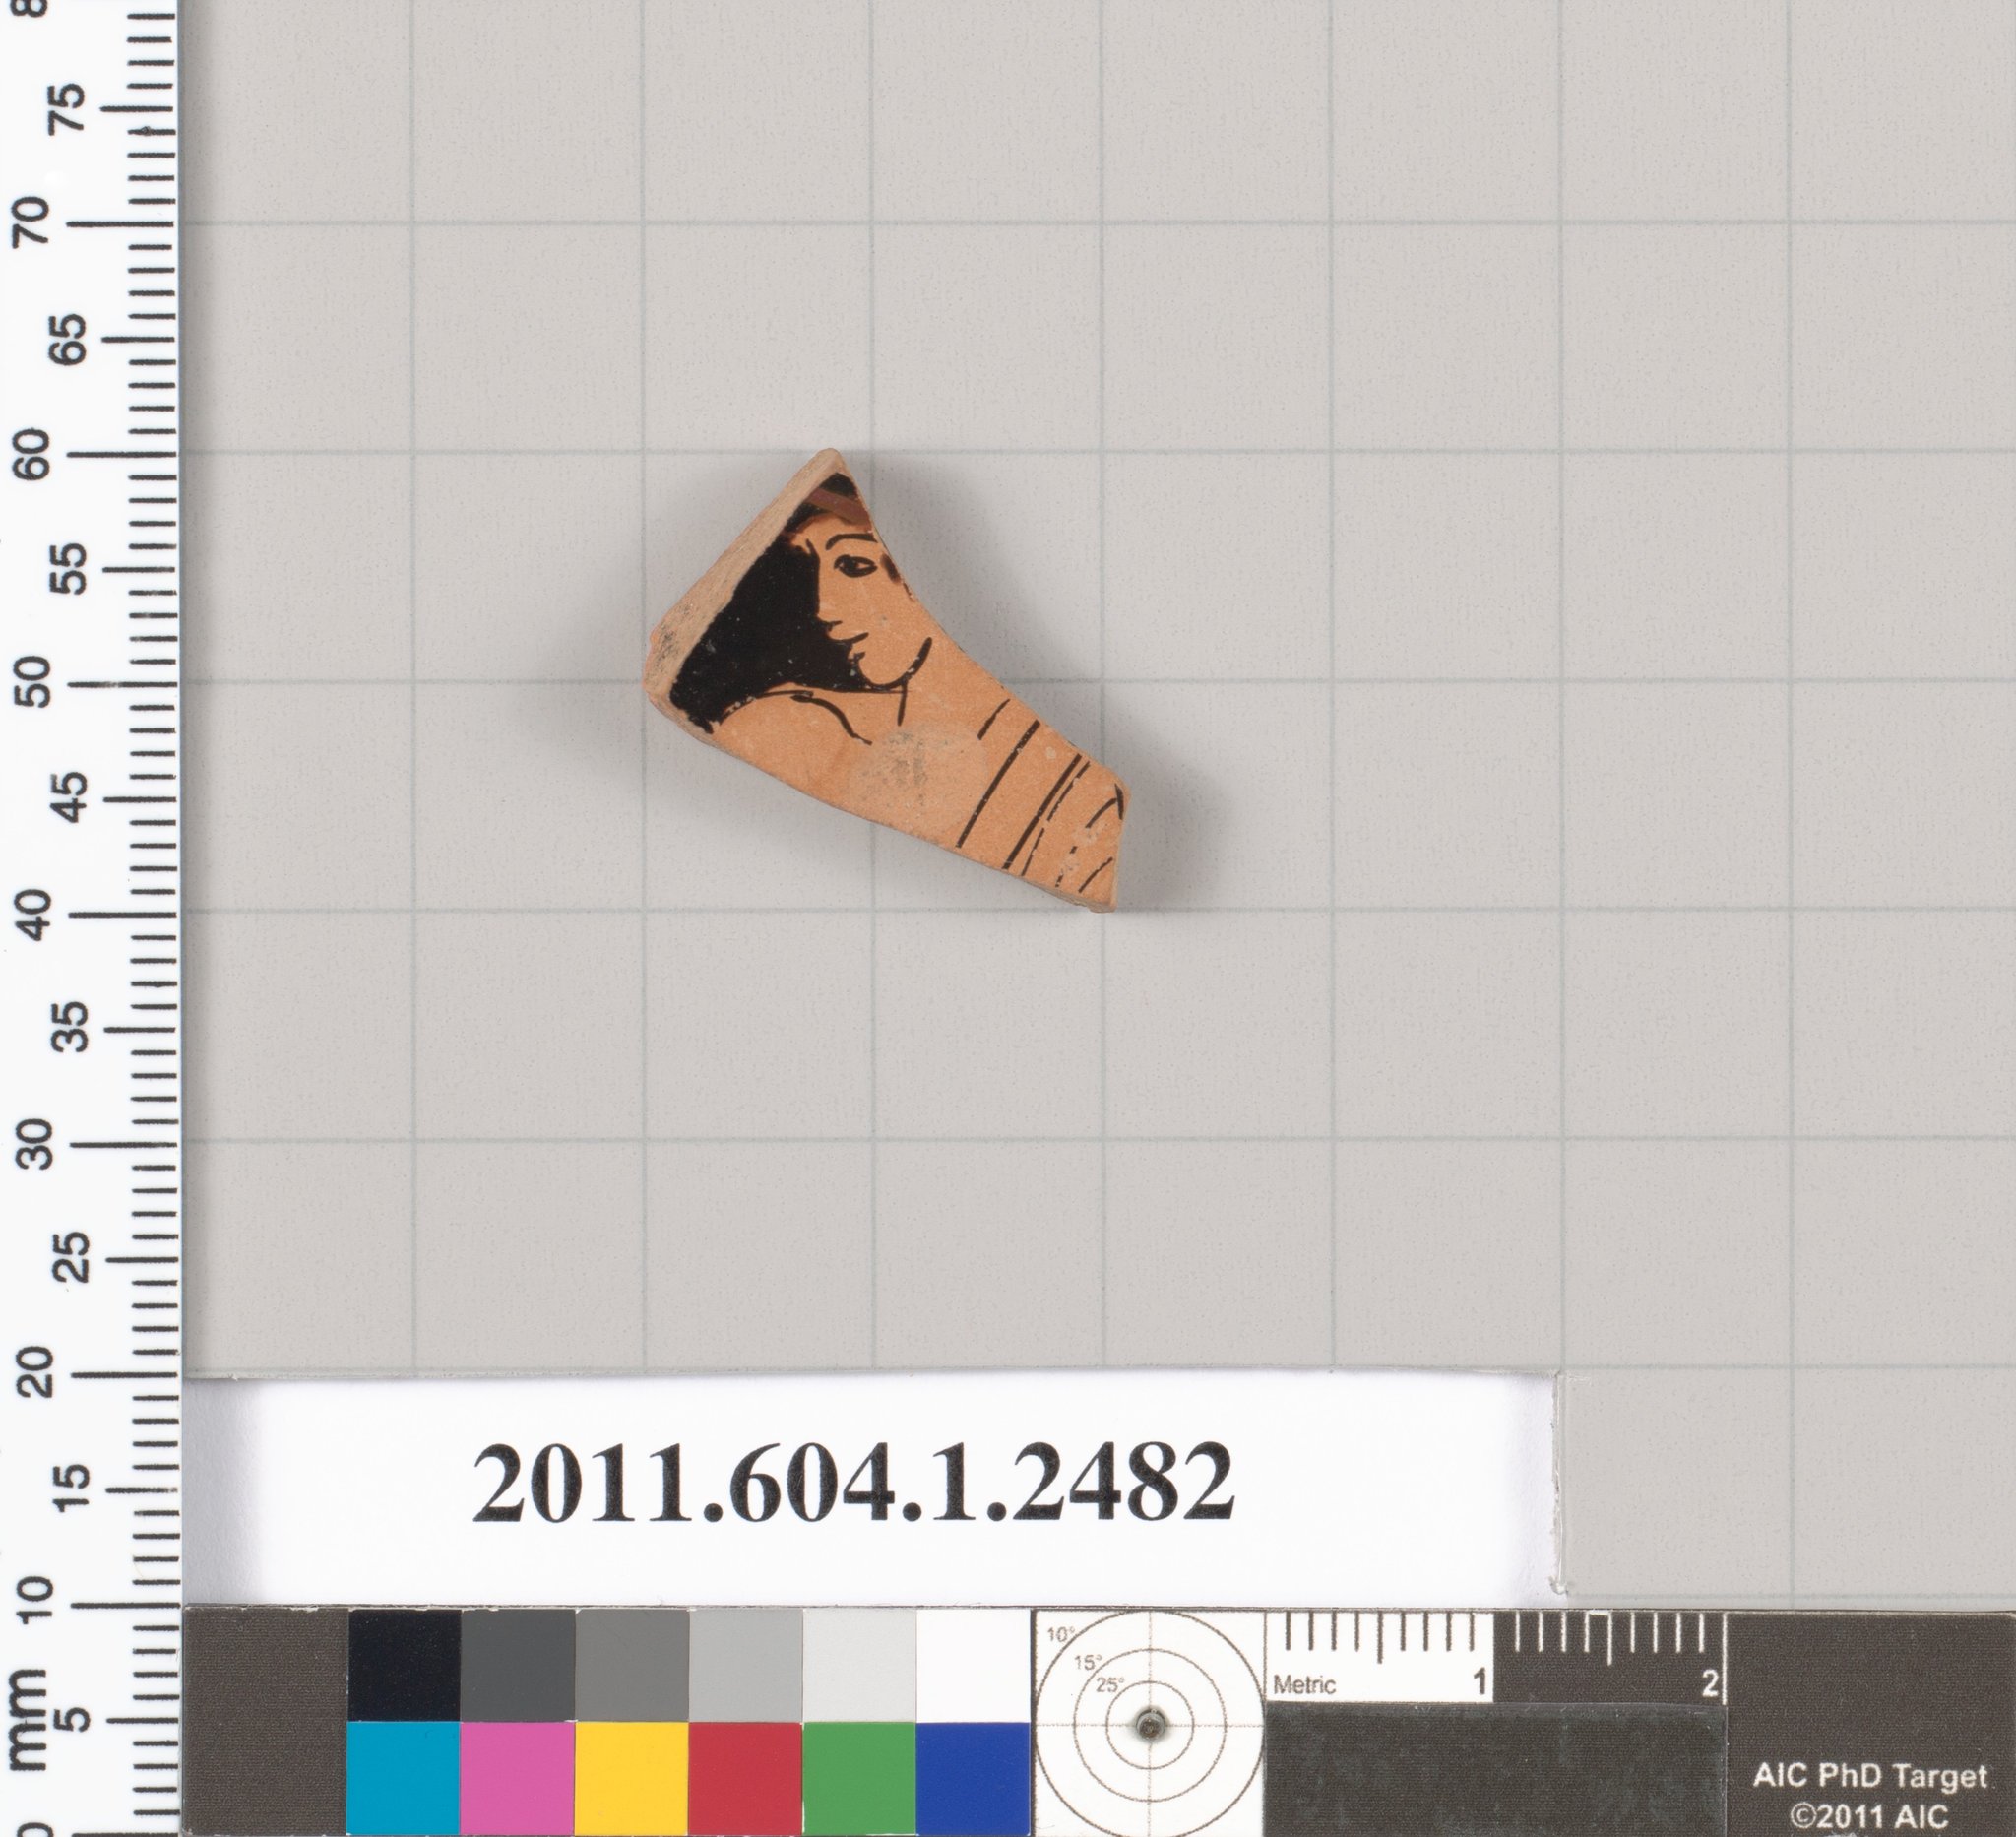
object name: kylix fragment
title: Terracotta fragment of a kylix (drinking cup)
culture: greek, attic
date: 475-451 BCE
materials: terracotta